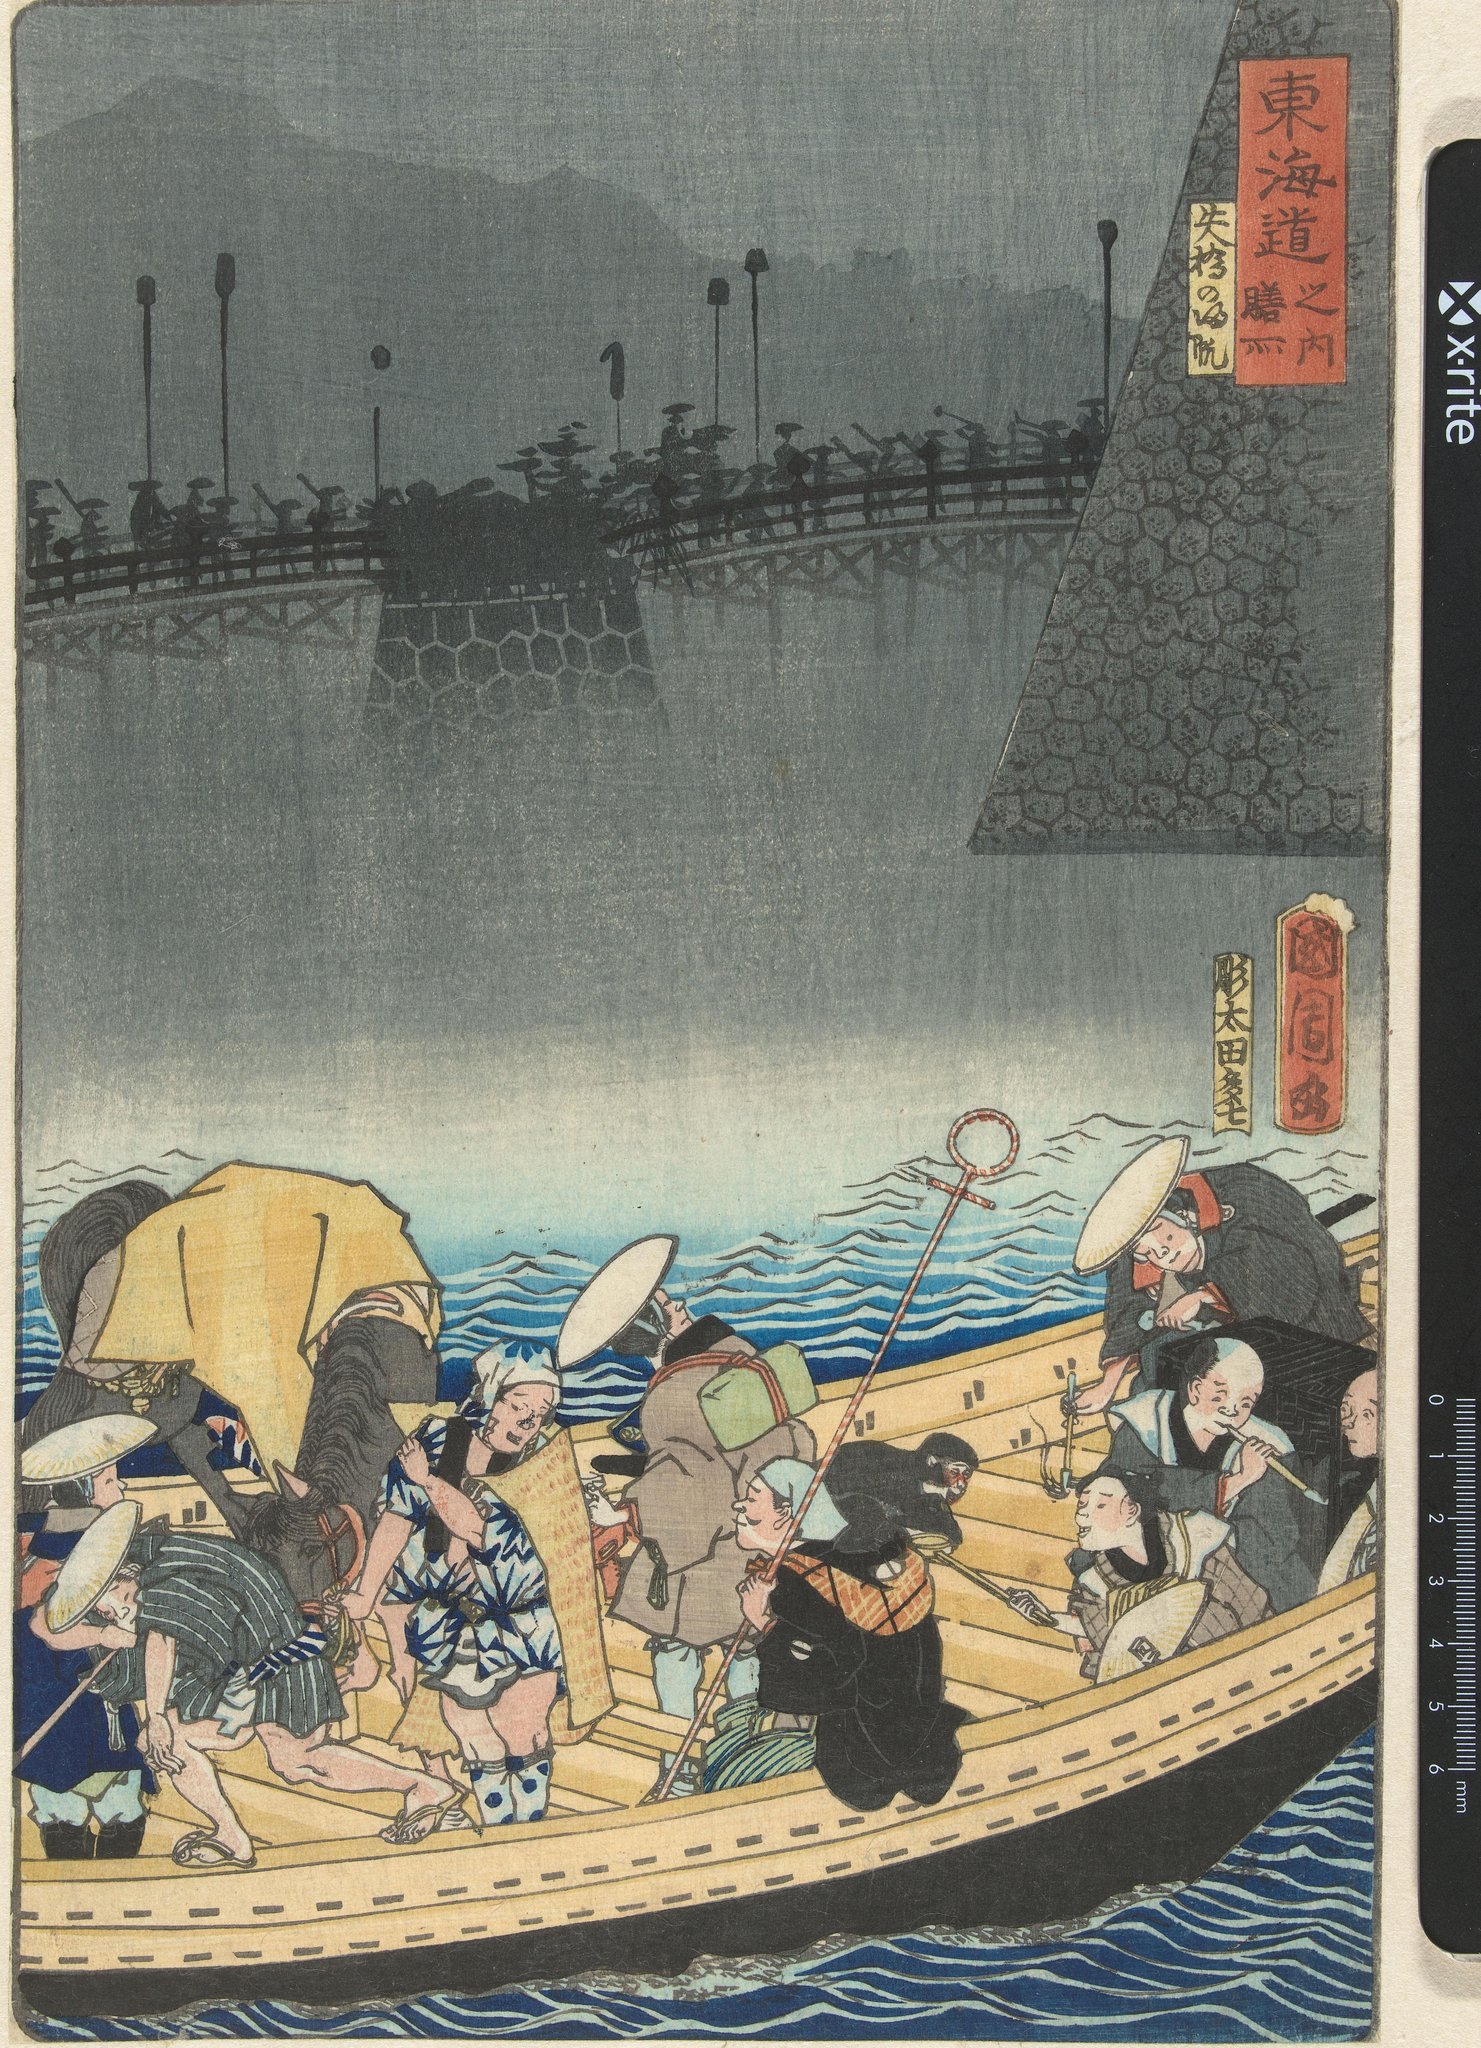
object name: print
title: Veerboot bij de pleisterplaats Zeze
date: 1863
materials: paper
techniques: woodcut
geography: japan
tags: ferry, horse, bridge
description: Boot met pijp rokende reizigers, een apendresseur en een paard, varend onderaan een stenen muur; op de achtergrond een brug waarop een parade.